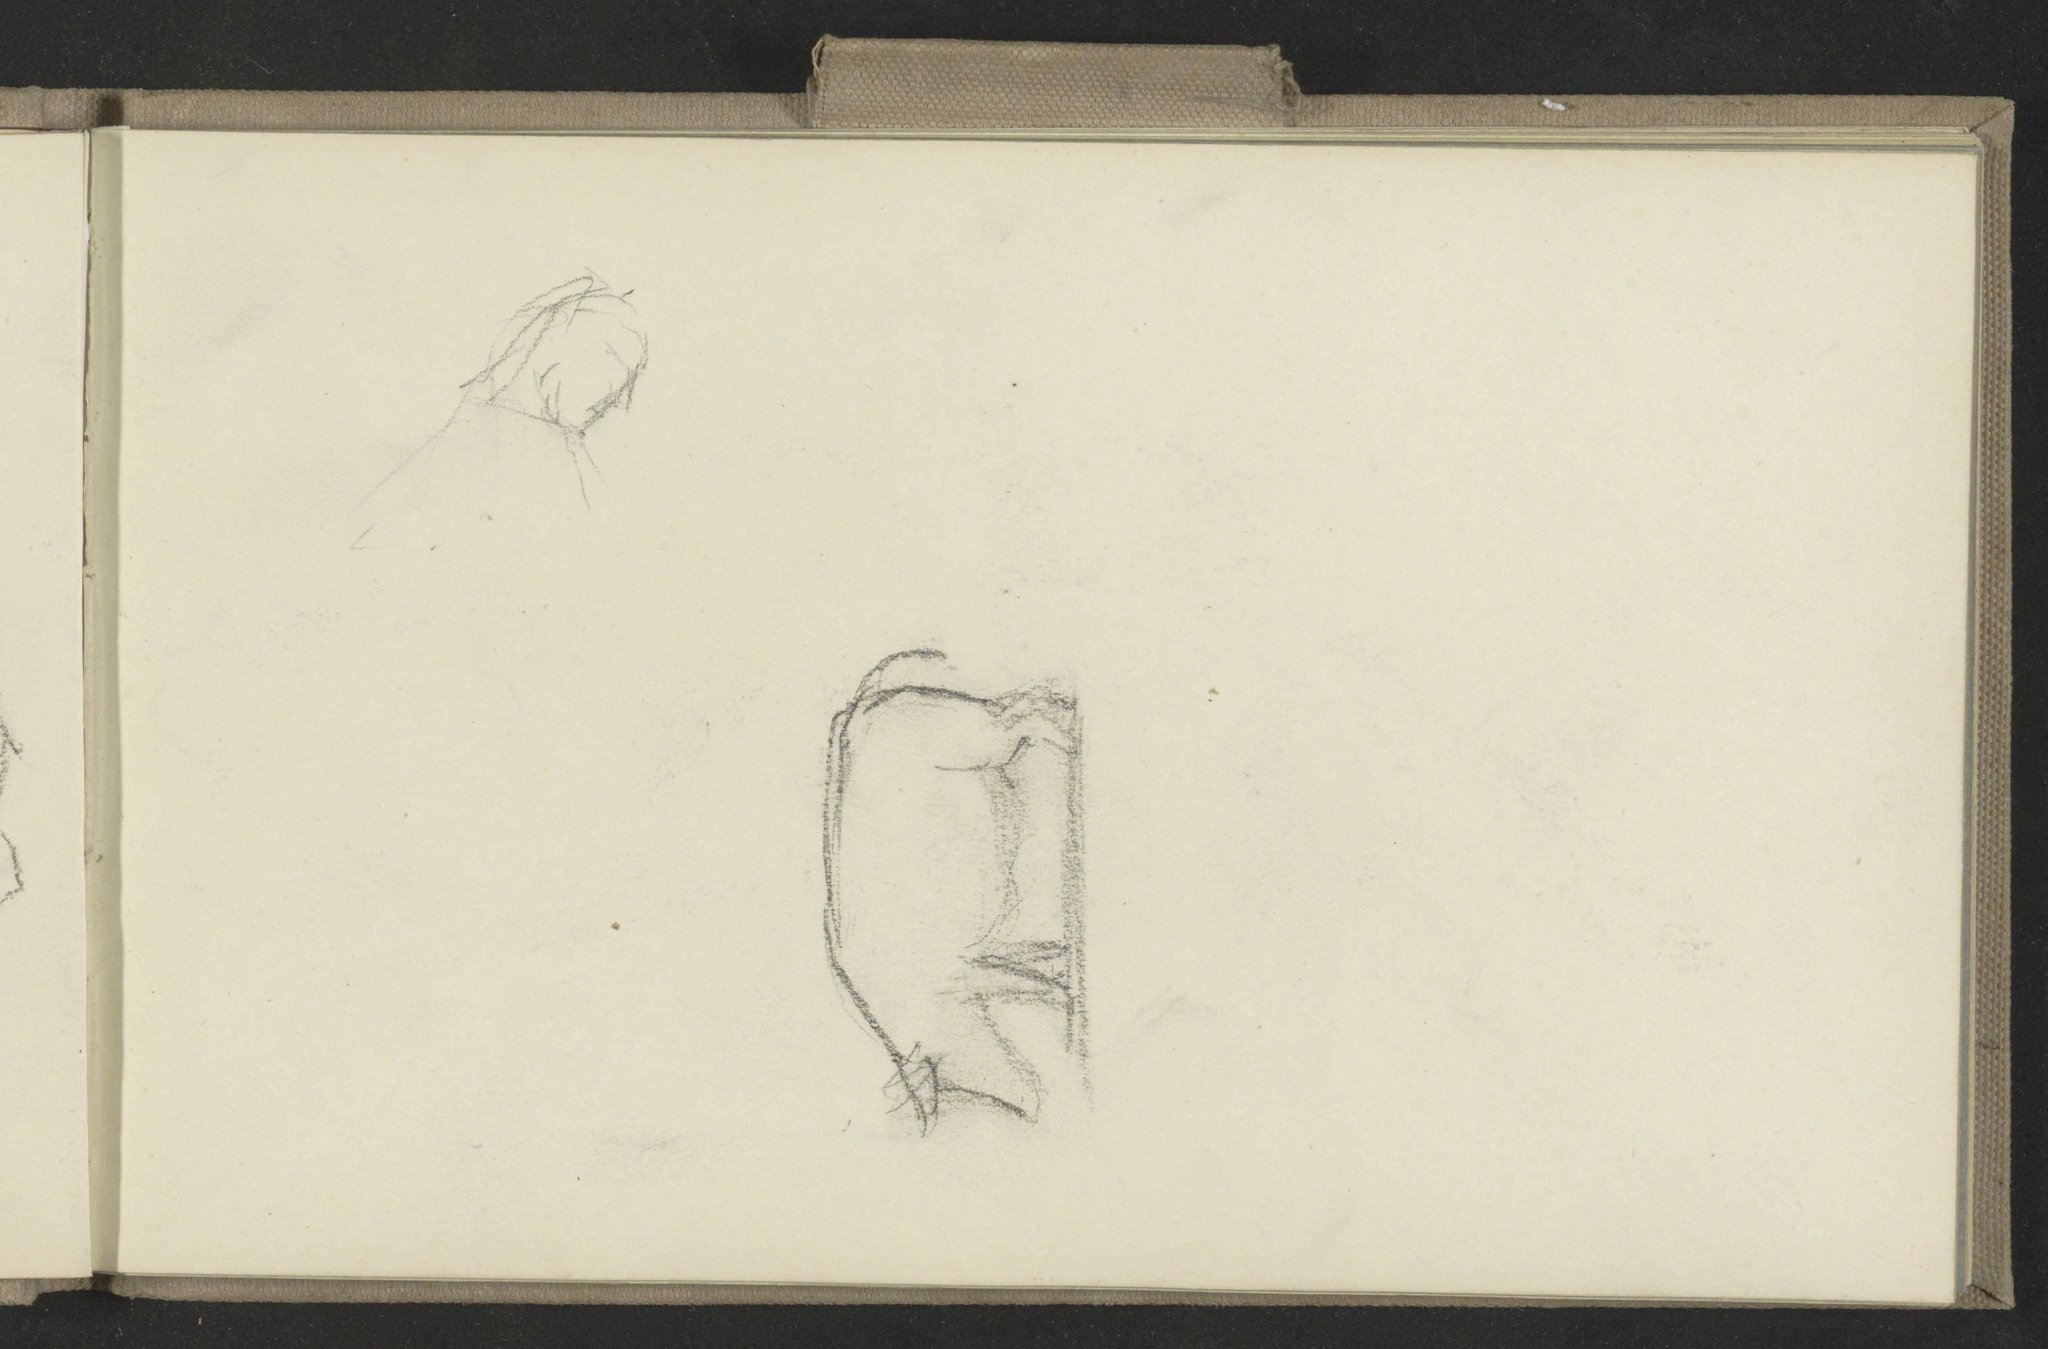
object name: sketchbook leaf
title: Mannenkop en een varken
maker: jozef israëls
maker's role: draughtsman, painter, print maker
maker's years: 1824-1911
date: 1834-1911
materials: paper, pencil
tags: pig, head (human) (+ male human being (not to be used where -a- is prescribed))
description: Blad 6 recto uit een schetsboek met 26 bladen.